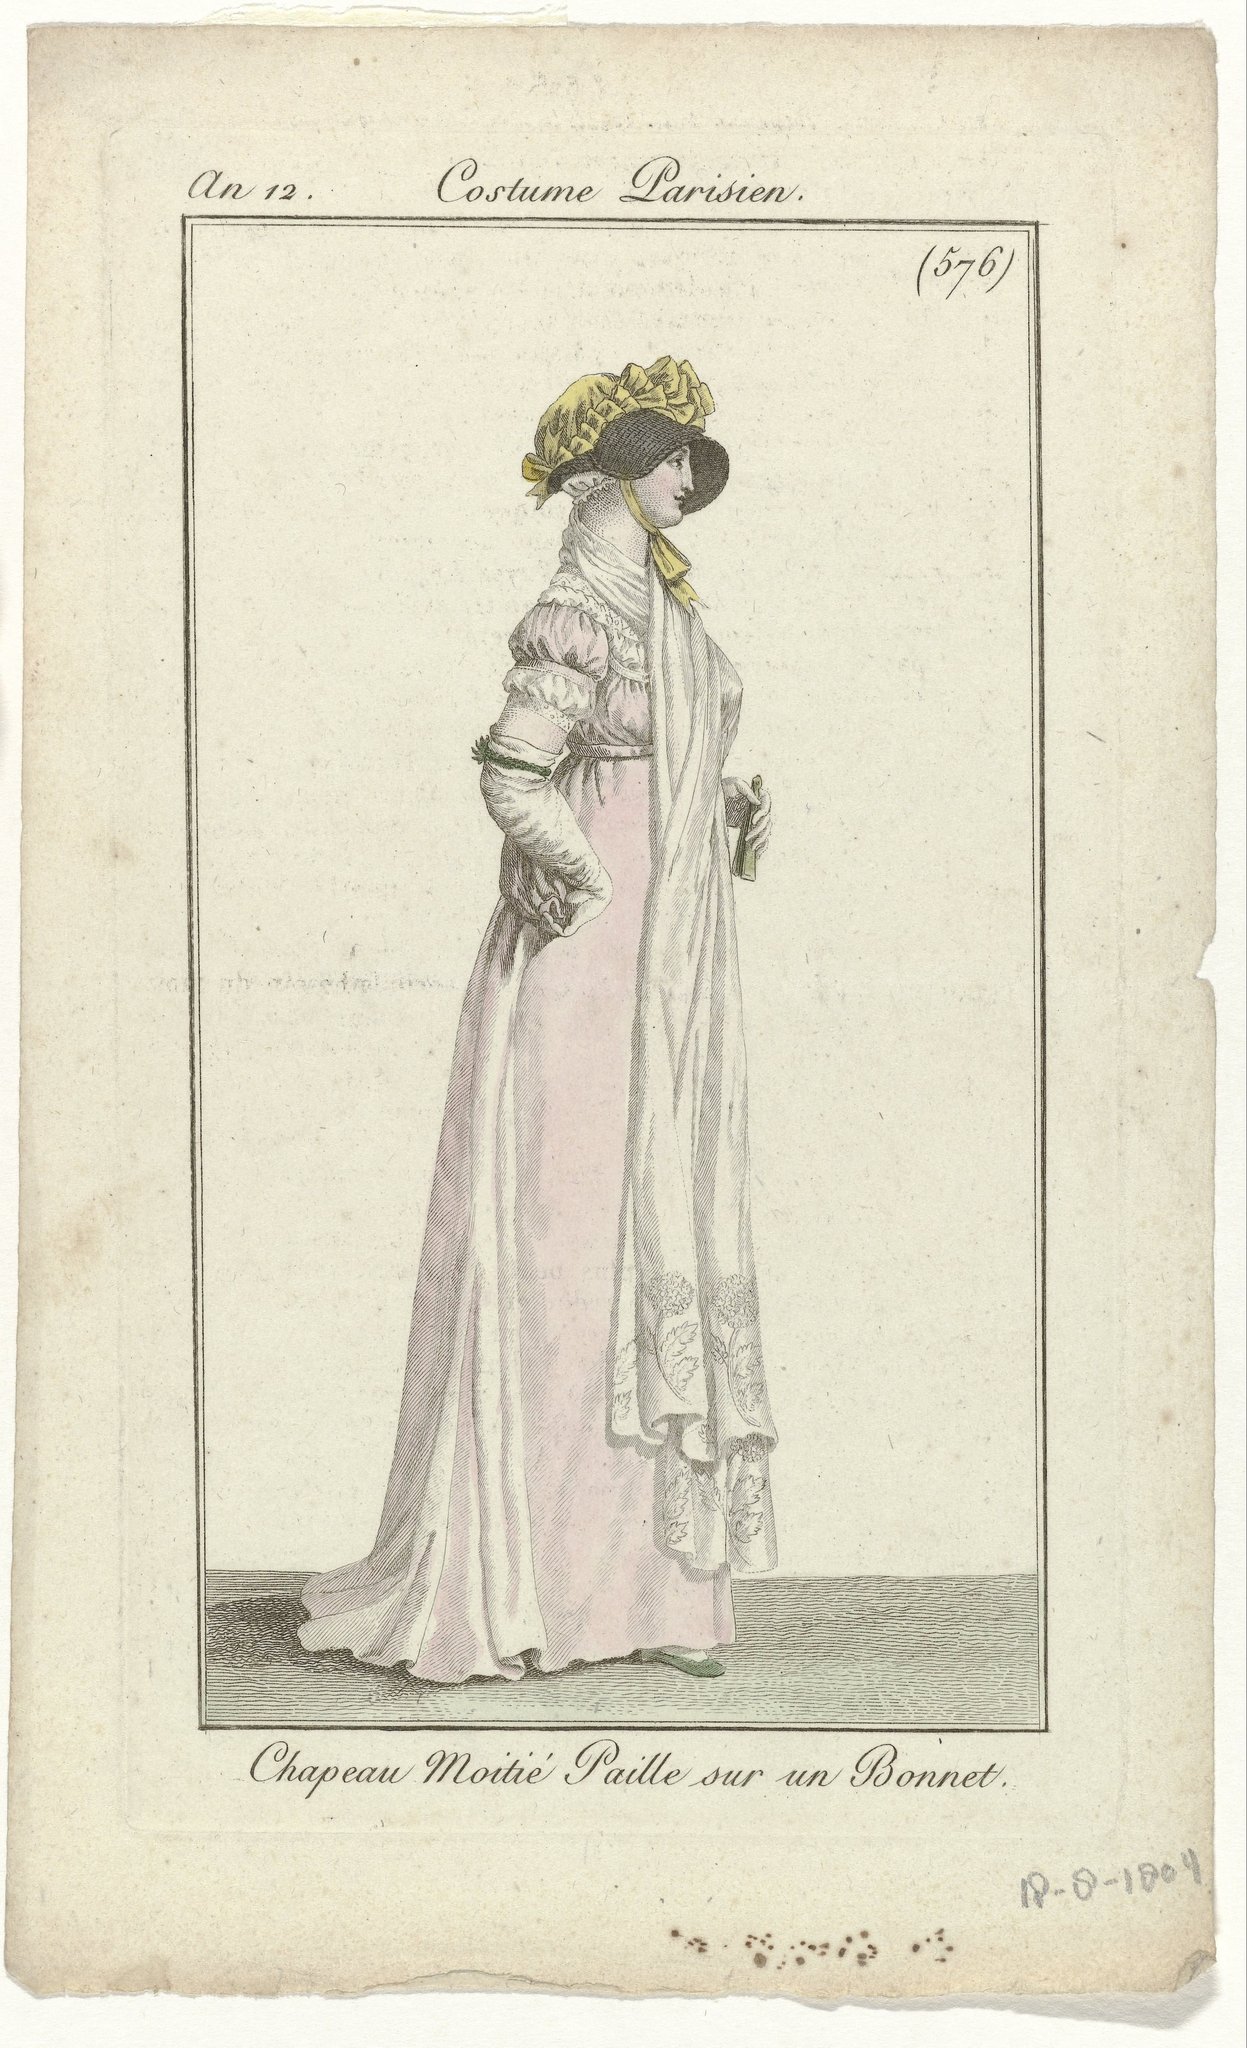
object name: fashion print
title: Journal des Dames et des Modes, Costume Parisien, 18 août 1804, An 12, (576): Chapeau Moitié Paill (...)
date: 1804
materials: paper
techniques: engraving, hand coloring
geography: paris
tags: gloves, mittens (long gloves) (+ women's clothes), clothing for the upper part of the body (shawl) (+ women's clothes), head-gear (straw hat) (+ women's clothes), head-gear: cap (+ women's clothes), fashion plates, shoes, sandals (+ women's clothes), dress, gown (+ women's clothes), fan (+ women's clothes)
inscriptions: caption: ‘Chapeau Moitié Paille sur un Bonnet.’, title: ‘Costume Parisien.’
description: Vrouw met op het hoofd een strohoed met een bol van stof op een muts. Zij draagt een japon met korte mouwen en sleep. Om de hals een lange sjaal, bij de zoom versierd met een bloemmotief. Verdere accessoires: lange handschoenen, armband om de rechterbovenarm, waaier, platte schoen. Met de rechterhand houdt ze de sleep van haar japon op. De prent maakt deel uit van het modetijdschrift Journal des Dames et des Modes, uitgegeven door Pierre de la Mésangère, Parijs, 1797-1839.